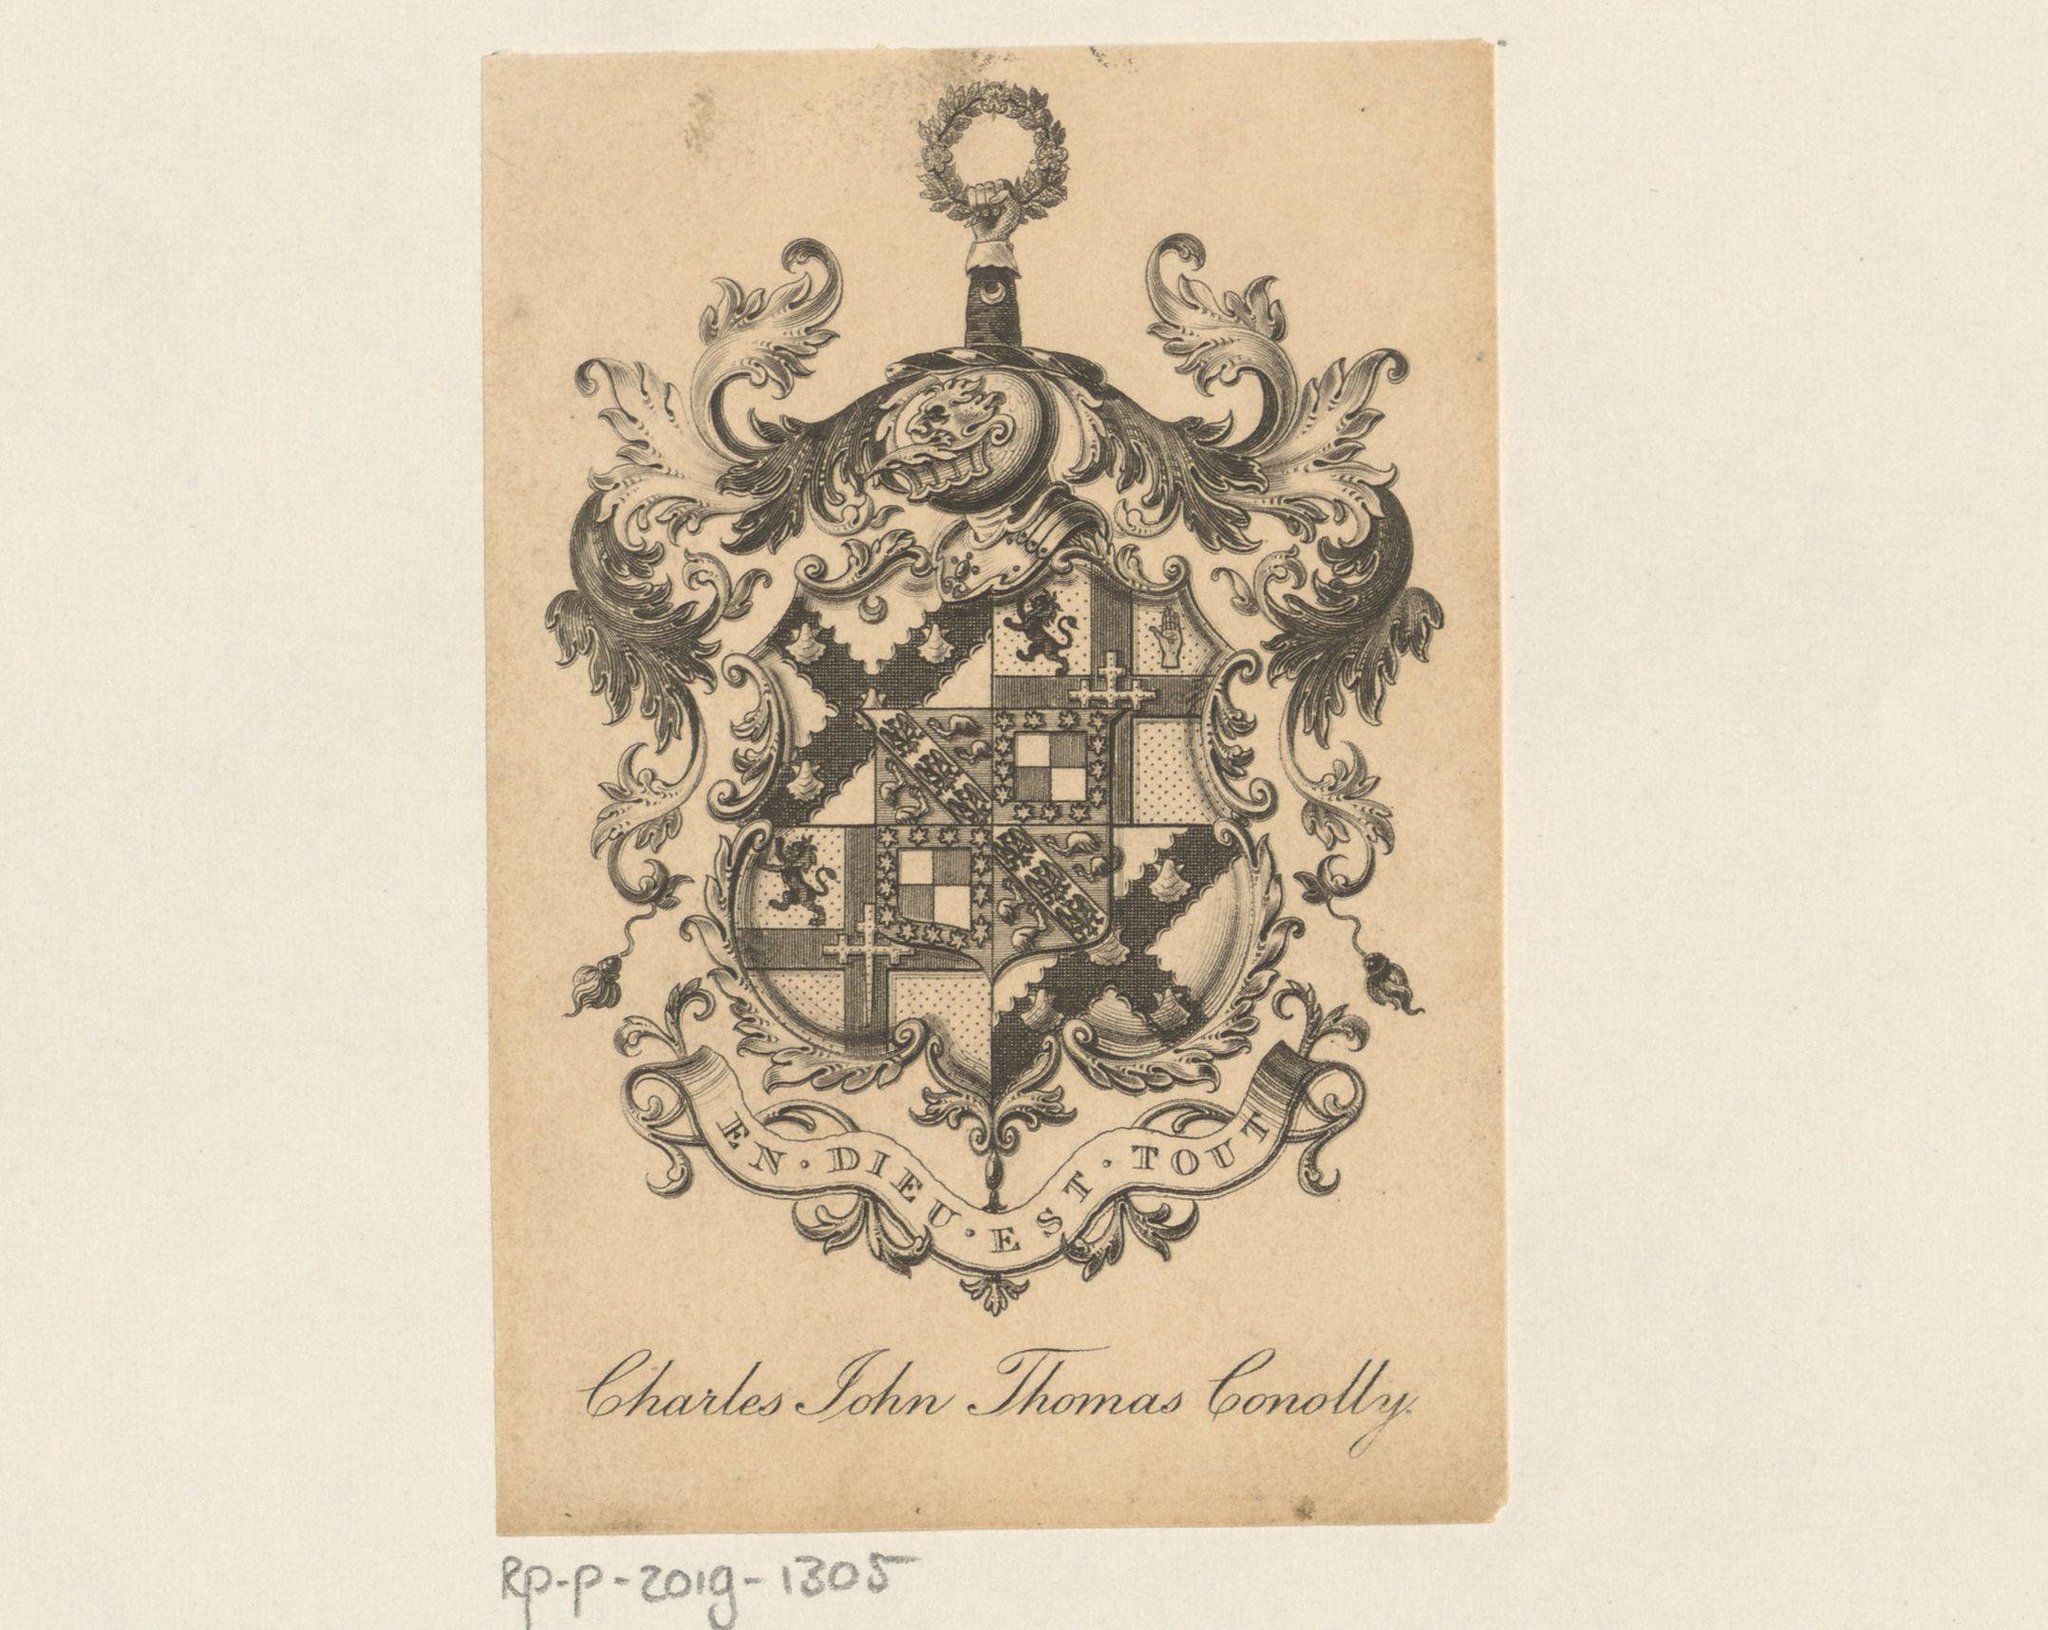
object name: bookplate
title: En dieu est tout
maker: Anonymous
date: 1750-1849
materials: paper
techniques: engraving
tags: armorial bearing, heraldry